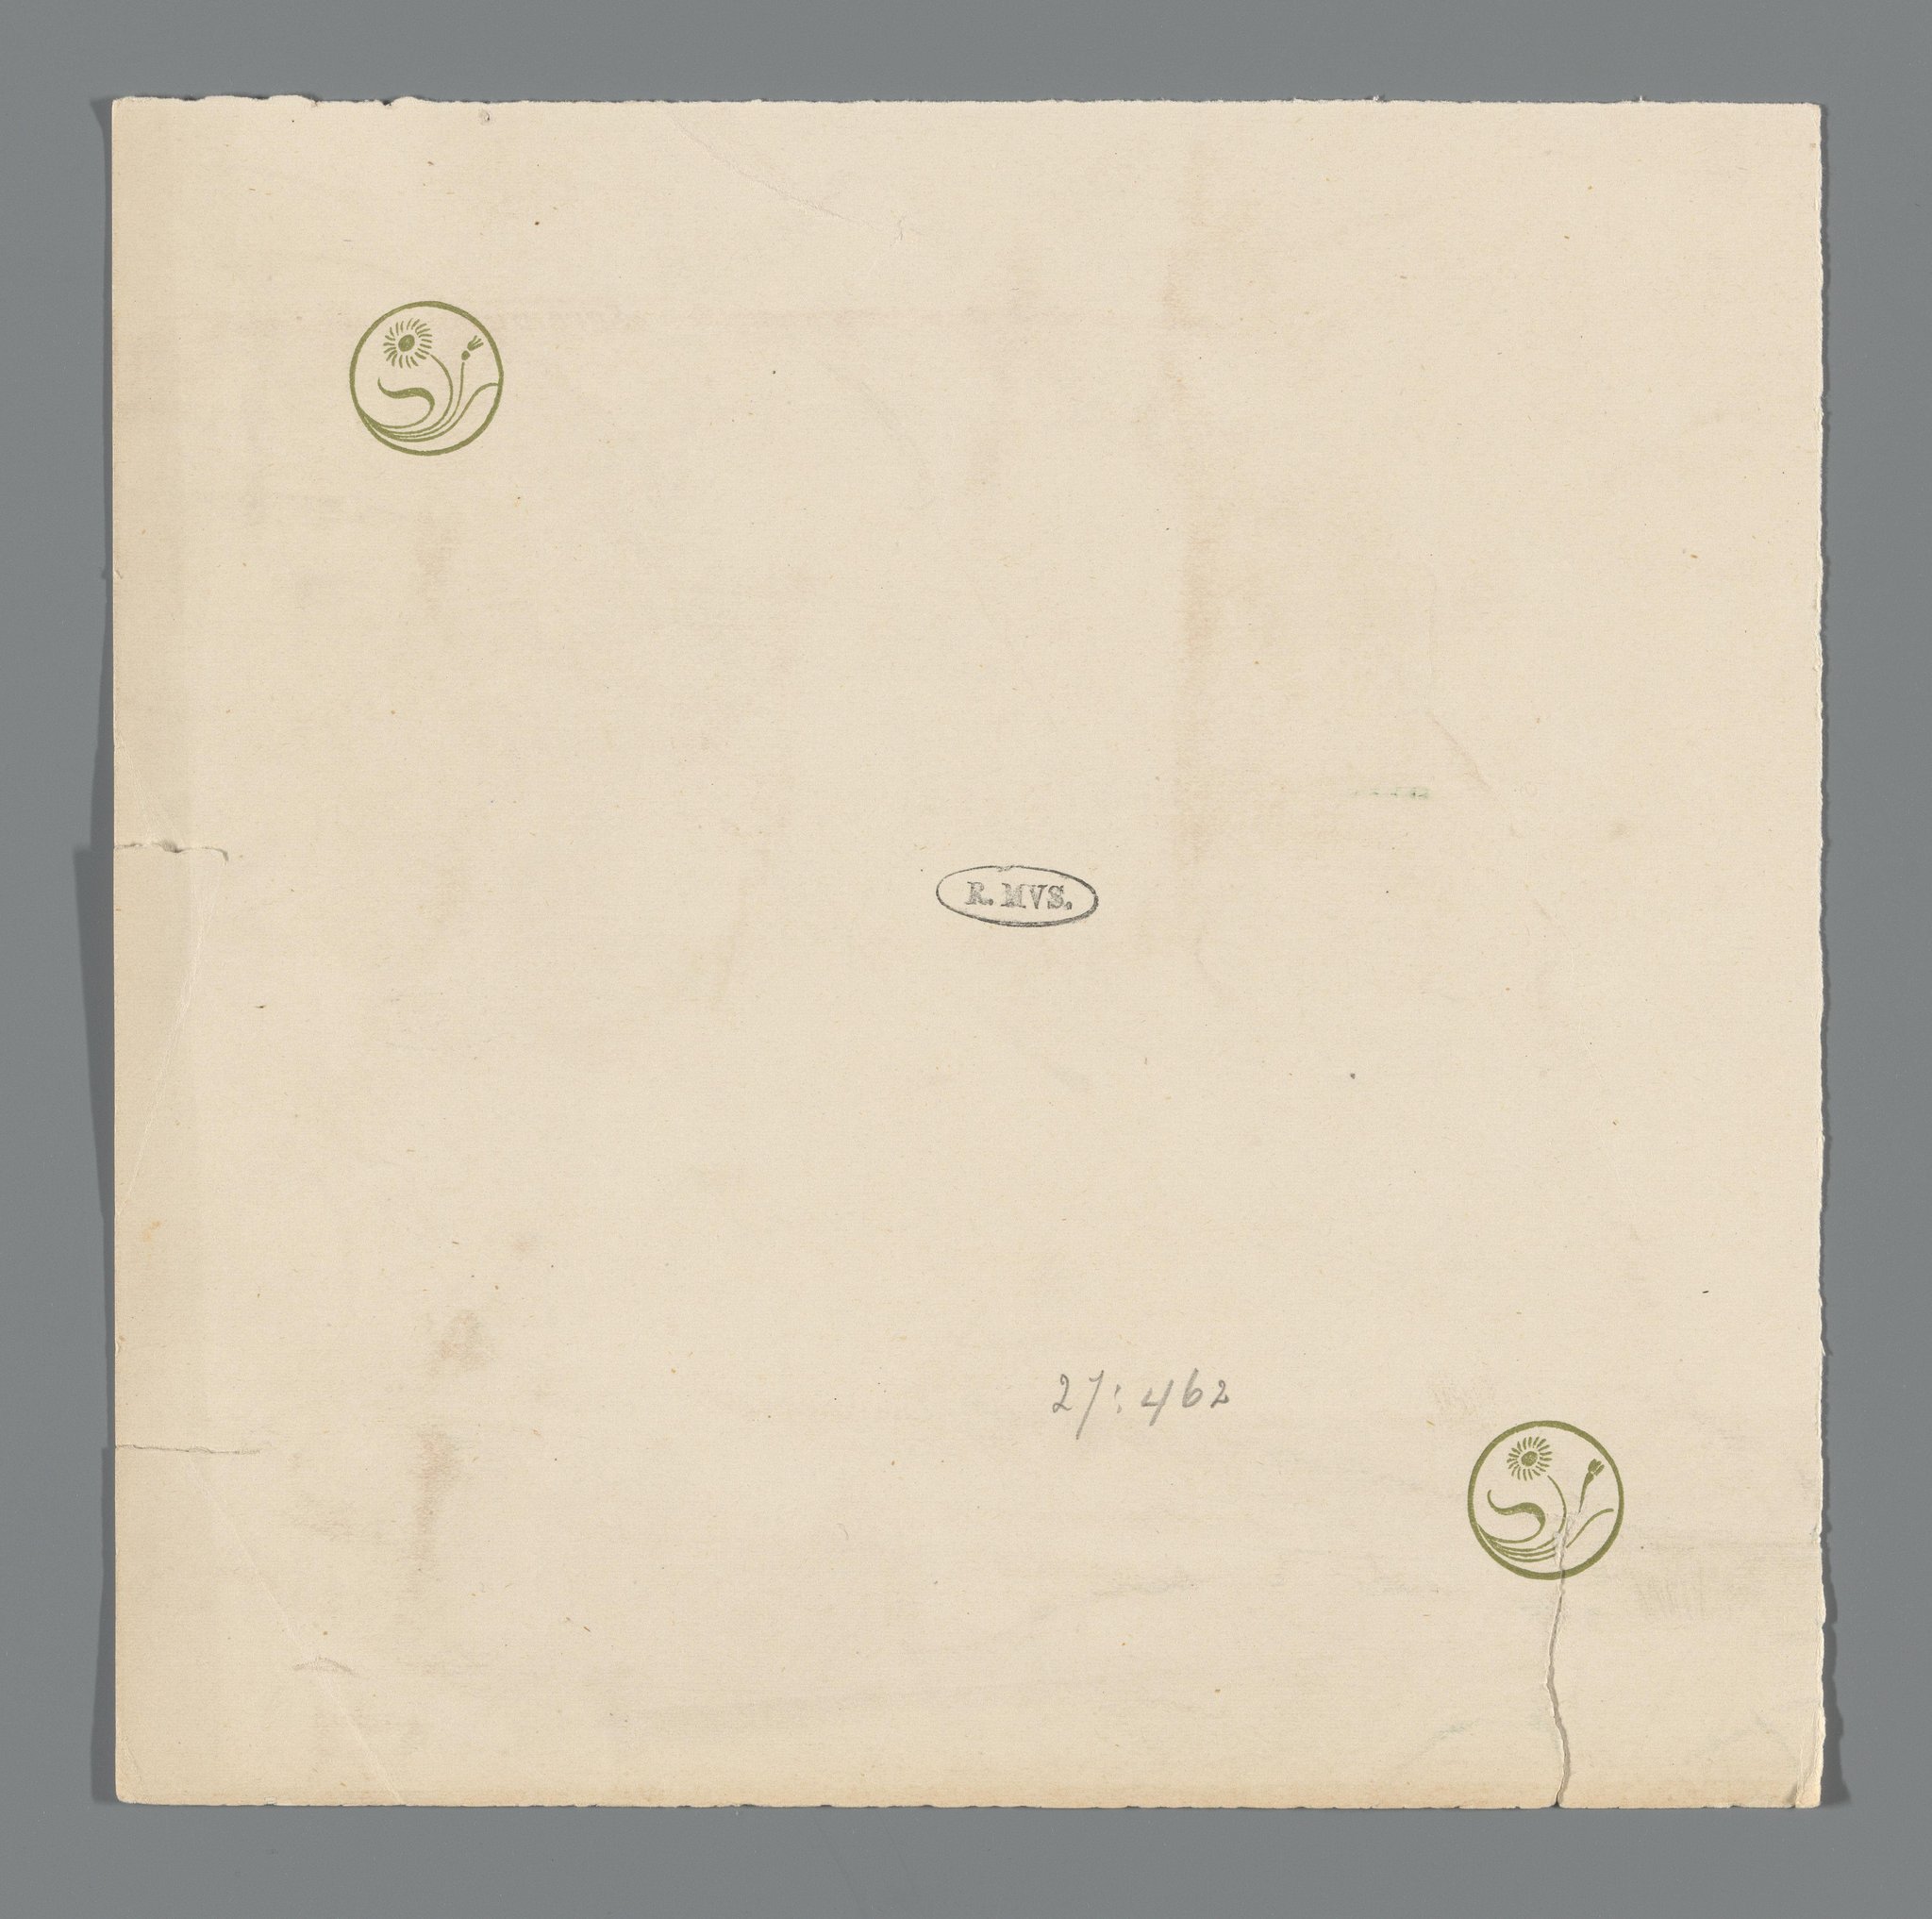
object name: book illustration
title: Cirkel met bloem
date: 1878-1927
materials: paper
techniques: engraving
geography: london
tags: flowers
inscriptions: collector's mark: Lugt 2228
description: Prent uit een tweede editie van: The baby's bouquet, a fresh bunch of old rhymes and tunes. Londen: Routledge & Sons, [1878]. Of een latere uitgave.